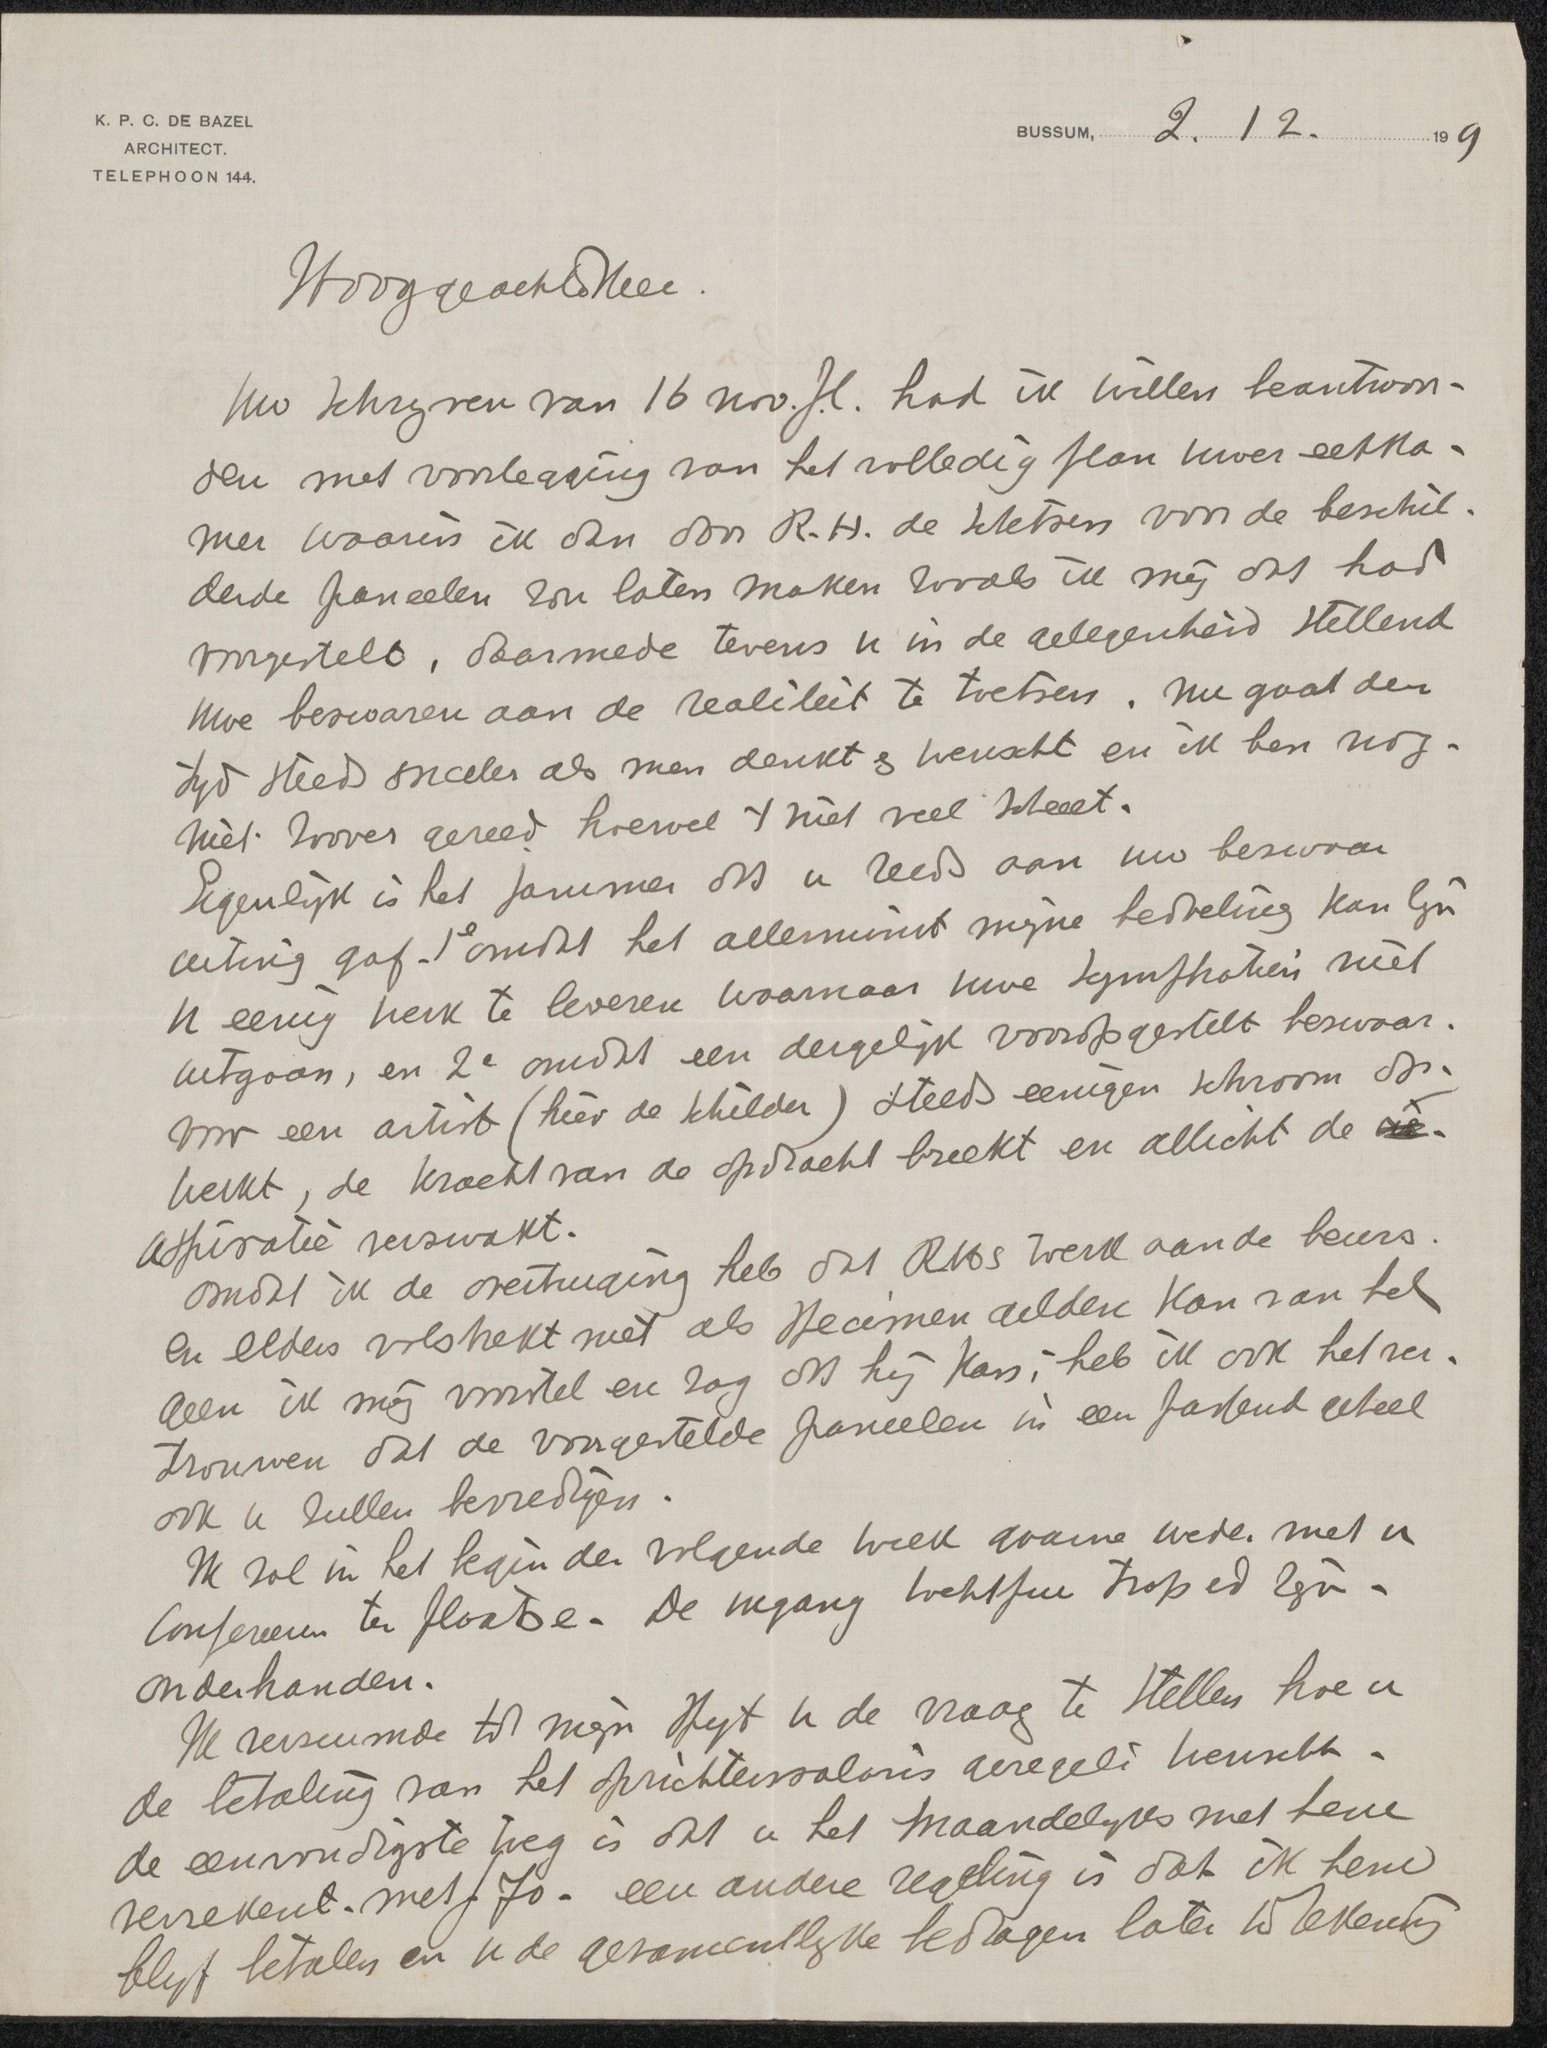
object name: letter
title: Brief aan Henricus Joannes van Ogtrop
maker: karel petrus cornelis de bazel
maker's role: draughtsman, print maker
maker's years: 1869-1923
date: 1909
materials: ink, paper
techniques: pen, printing, writing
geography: bussum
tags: richard nicolaüs roland holst, the monumental arts, architecture, money